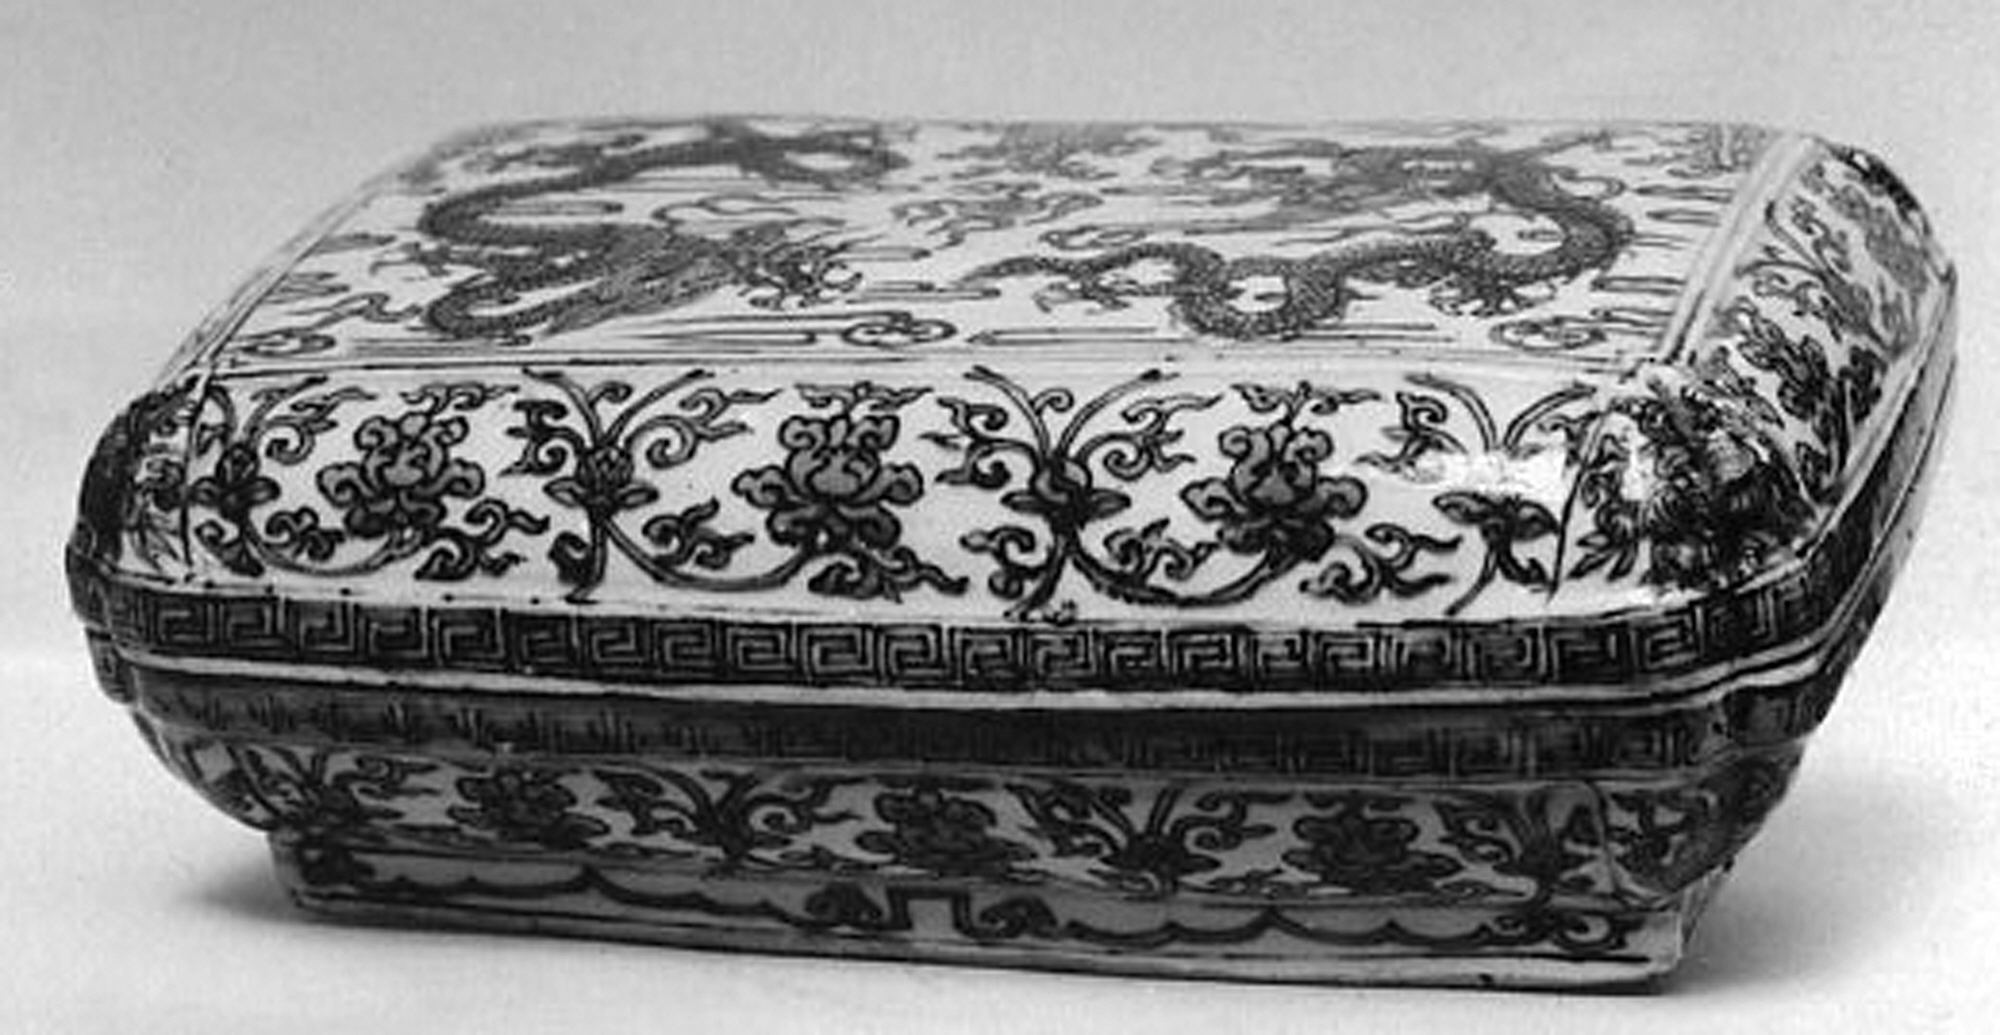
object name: covered box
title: Rectangular box with double dragons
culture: chinese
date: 1573-1620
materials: cobalt, glaze, porcelain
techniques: painting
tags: dragons